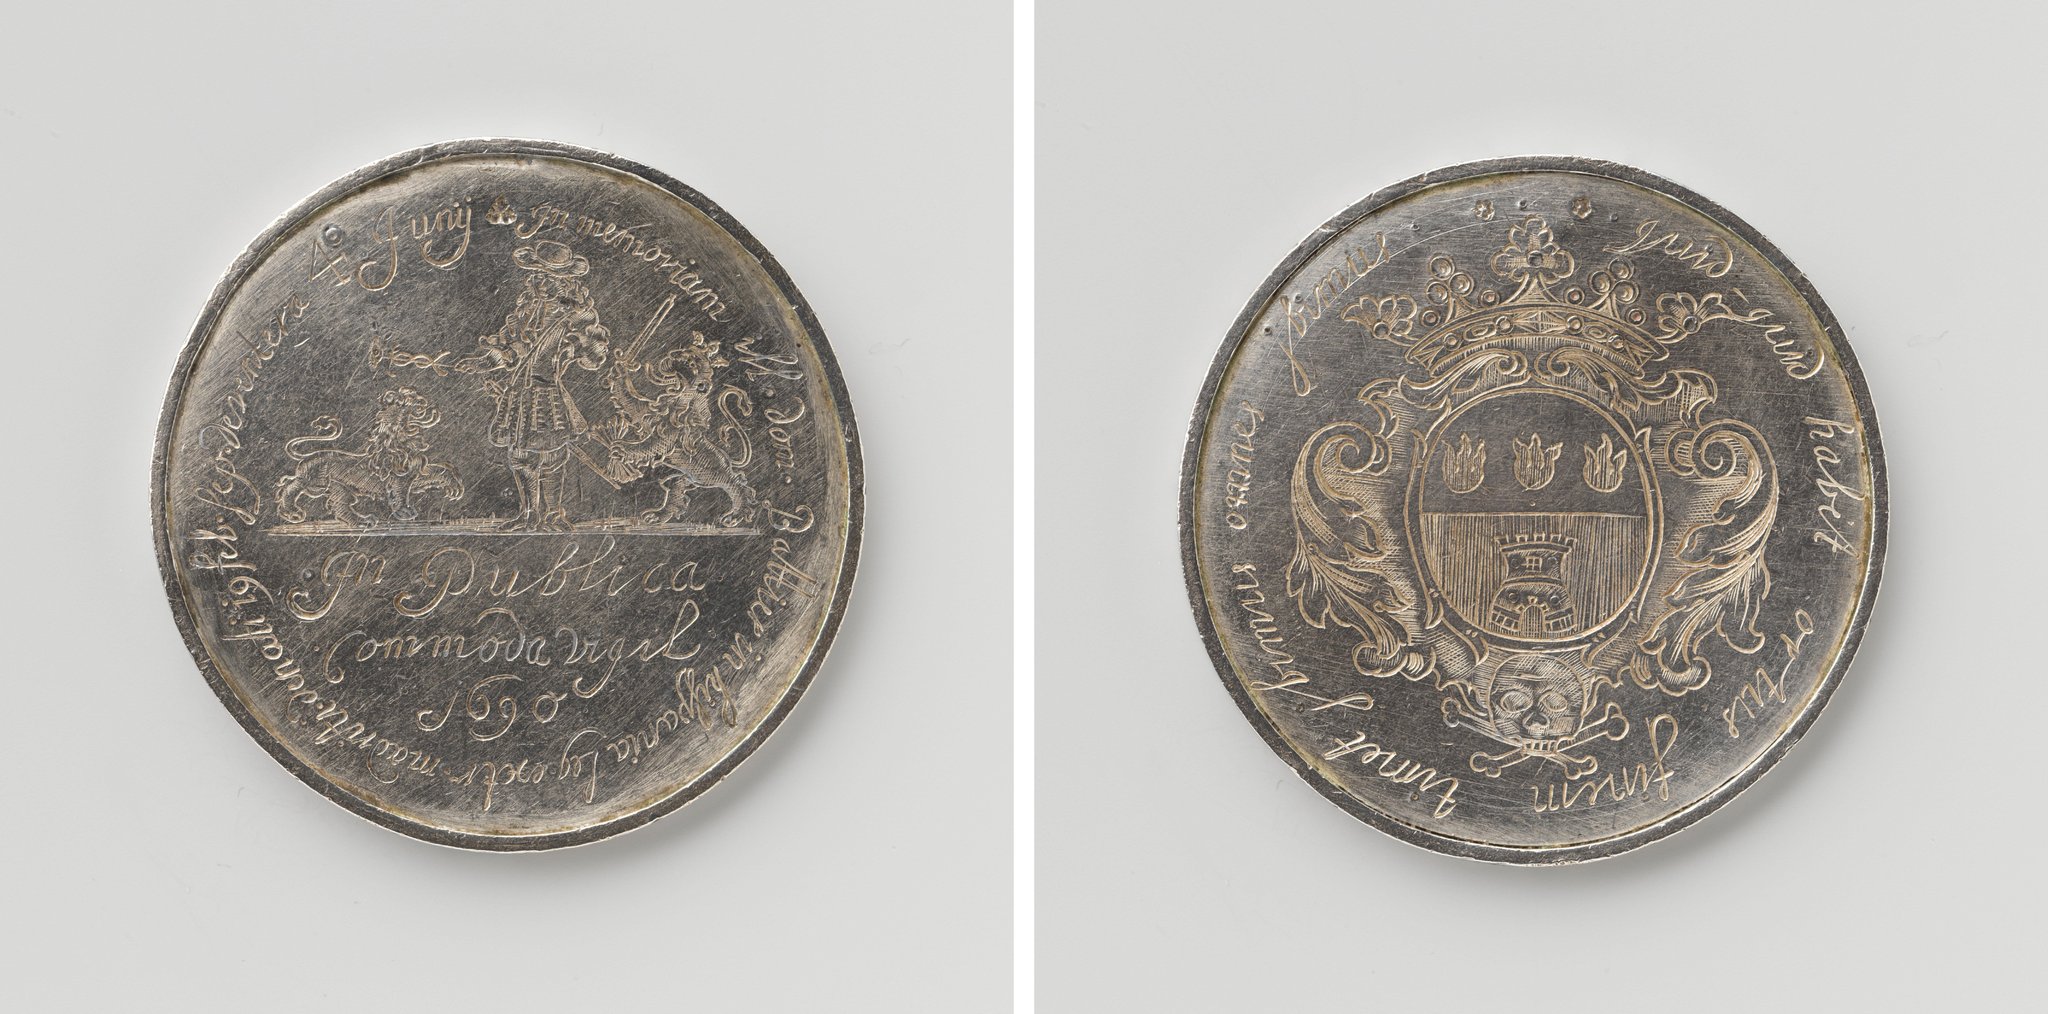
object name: overlijdenspenning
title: Overlijden van Pieter Battier tot de Pekkedam, buitengewoon gezant in Spanje, begraven te Deventer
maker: Anonymous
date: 1690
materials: silver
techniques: engraving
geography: netherlands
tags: deventer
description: Zilveren penning. Voorzijde: man met Mercuriusstaf tussen twee leeuwen, waarvan rechter met kroon, zwaard en pijlenbundel boven opschrift, binnen omschrift. Keerzijde: gekroond wapenschild boven doodshoofd binnen omschrift